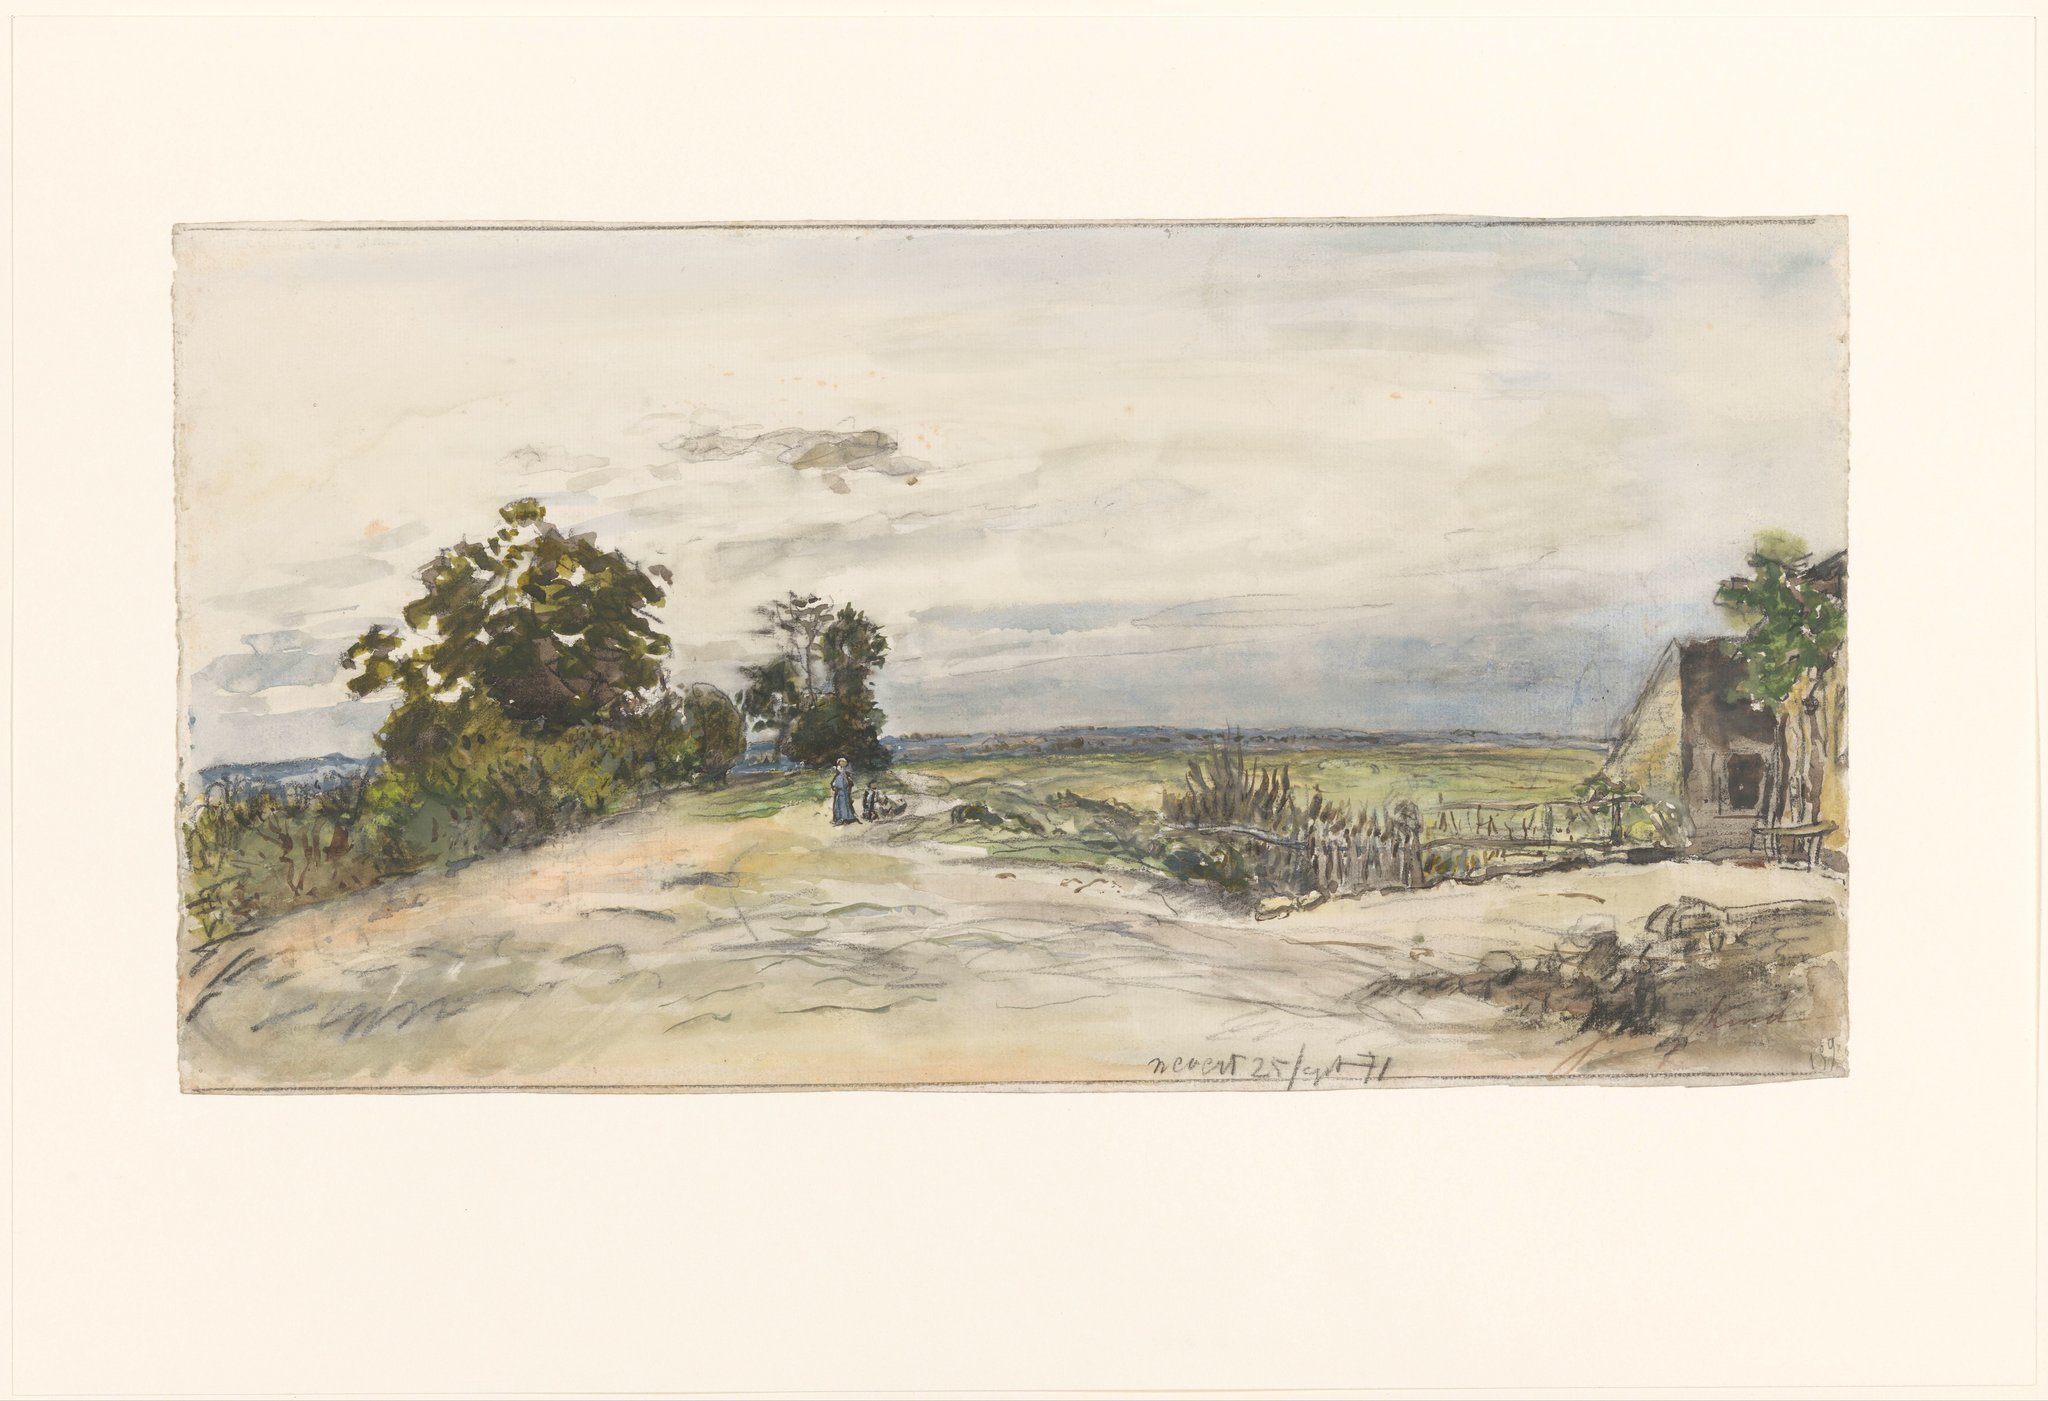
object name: watercolor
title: Landschap bij Nevers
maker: johan barthold jongkind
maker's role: draughtsman, painter, print maker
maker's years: 1819-1891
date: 1871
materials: chalk, paper, watercolor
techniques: brush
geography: nevers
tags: landscapes in the temperate zone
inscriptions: inscription: ‘nevers 25 sept 71’